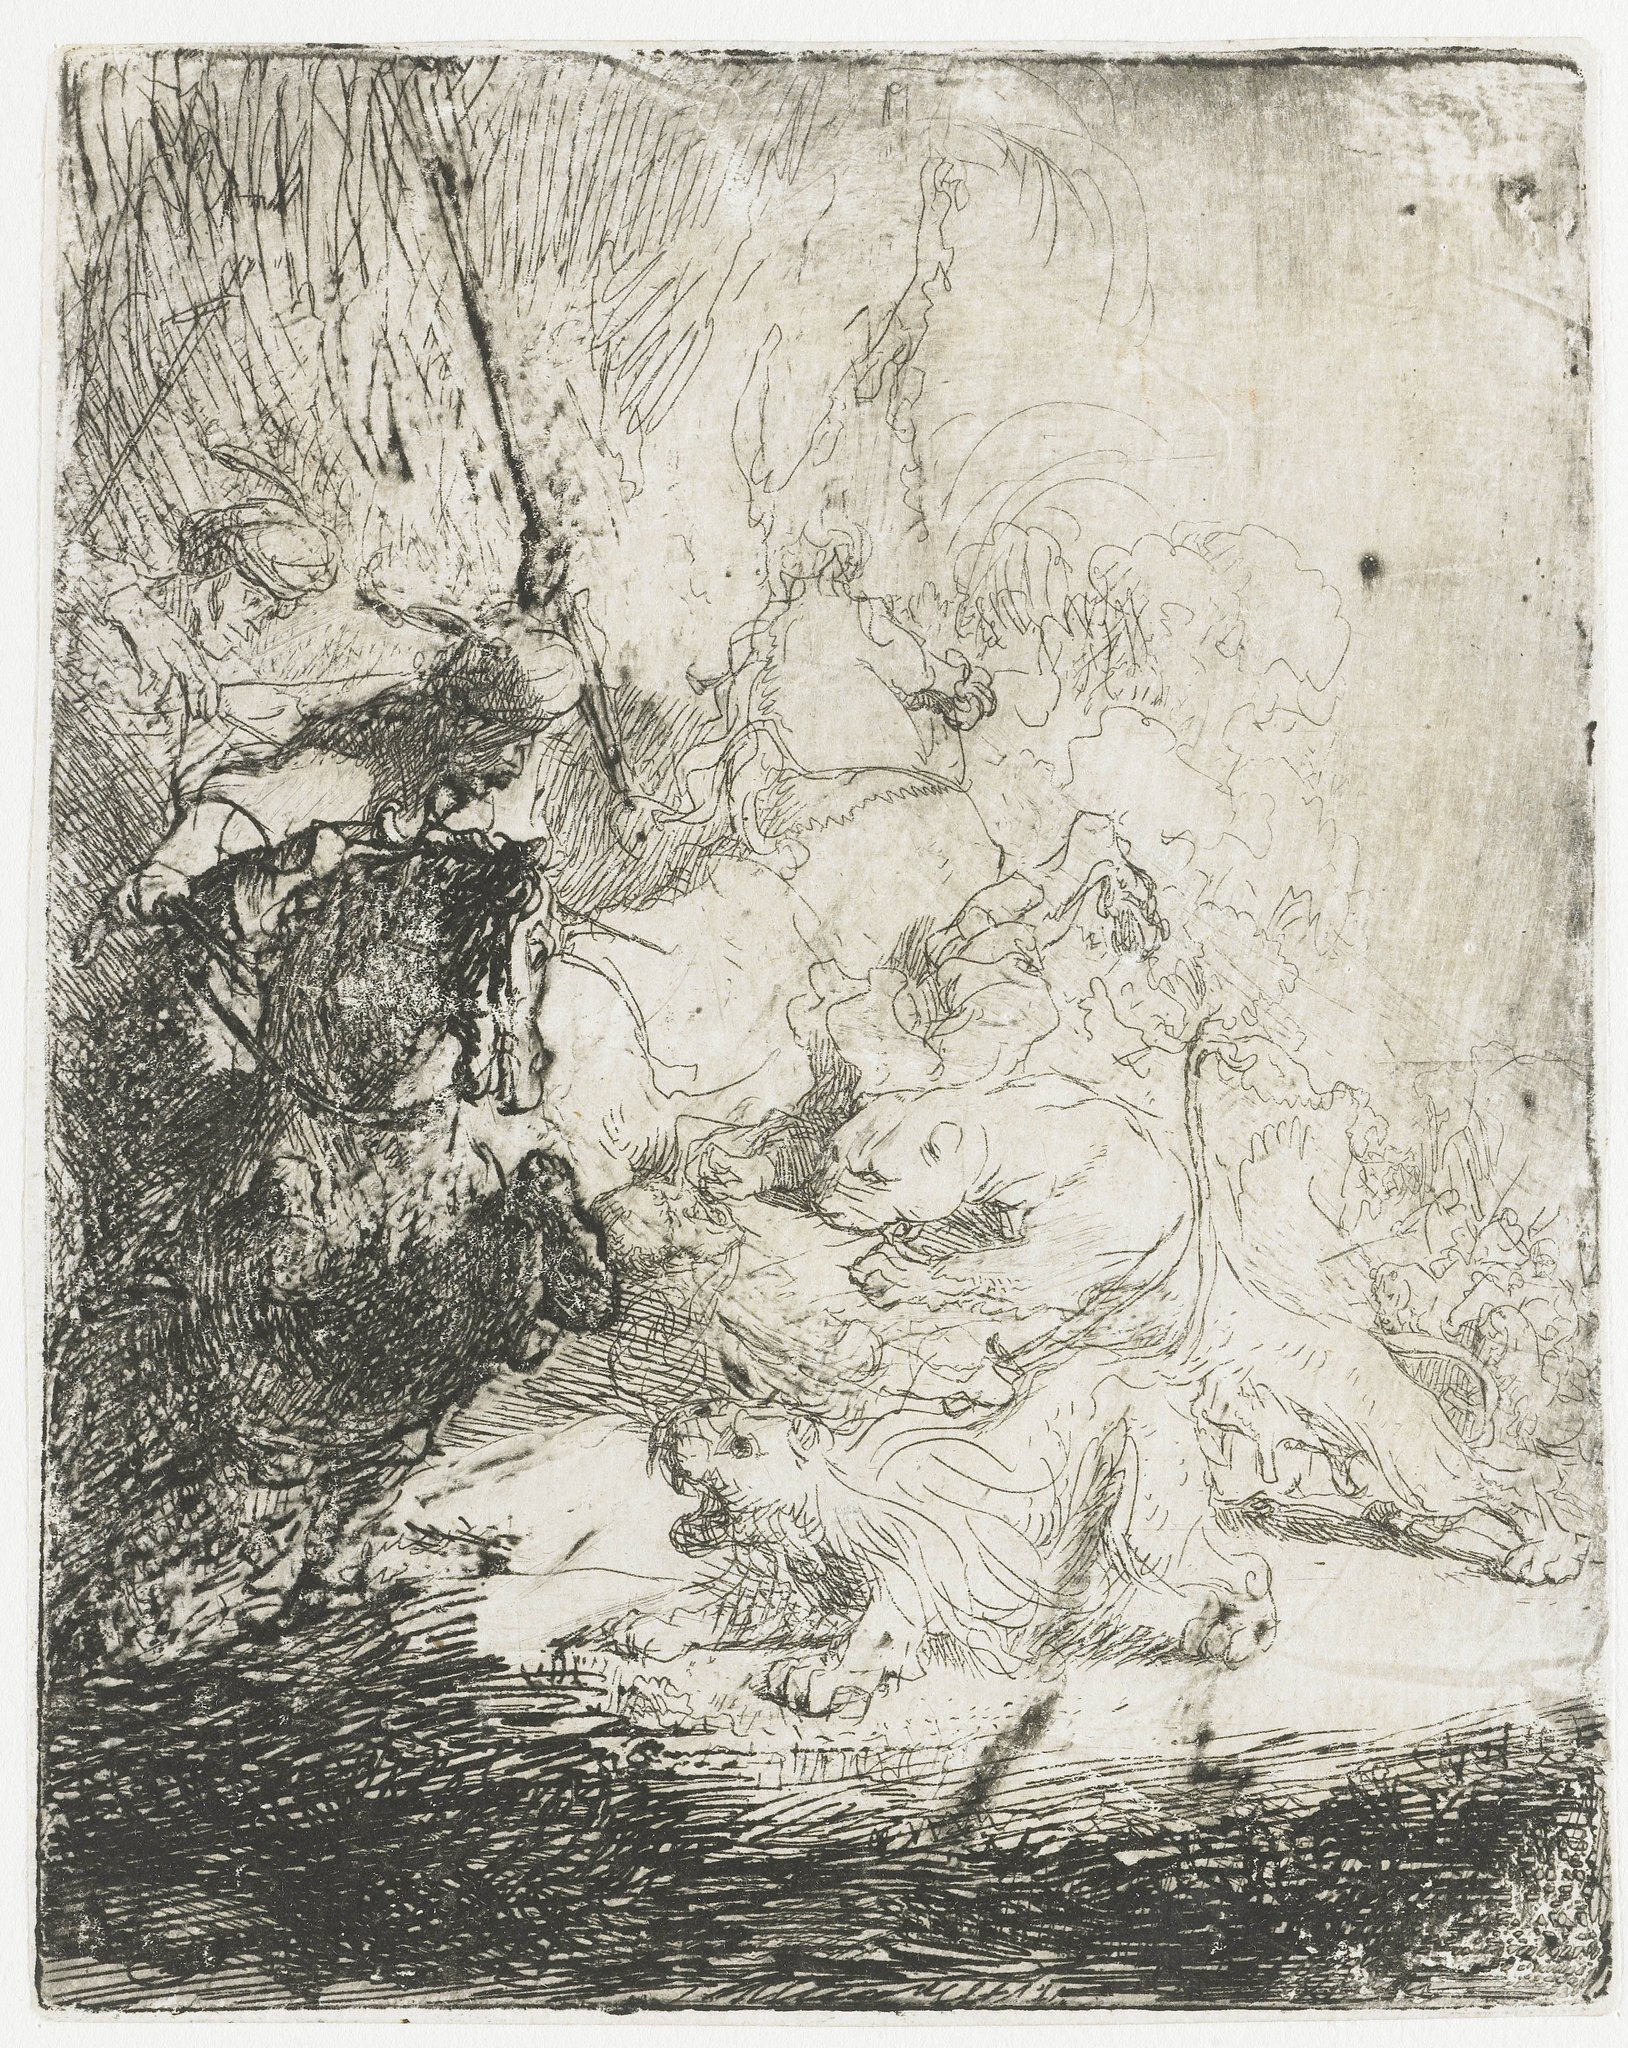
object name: print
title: The small lion hunt (with two lions)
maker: rembrandt van rijn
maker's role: draughtsman, painter, print maker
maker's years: 1606-1669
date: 1629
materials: paper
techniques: etching, intaglio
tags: lion hunt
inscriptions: mark: Lugt 1227, mark: Lugt 2228, mark: Lugt 654, mark: Lugt 240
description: Hunting scenes are a popular theme in art. They feature not only in tapestries and paintings, but also in series of prints. Rembrandt, too, was fascinated by them. In these three etchings, he attempts to capture the excitement and chaos of such violent encounters between men and animals. He further intensifies the drama by means of stark contrasts of light and dark.